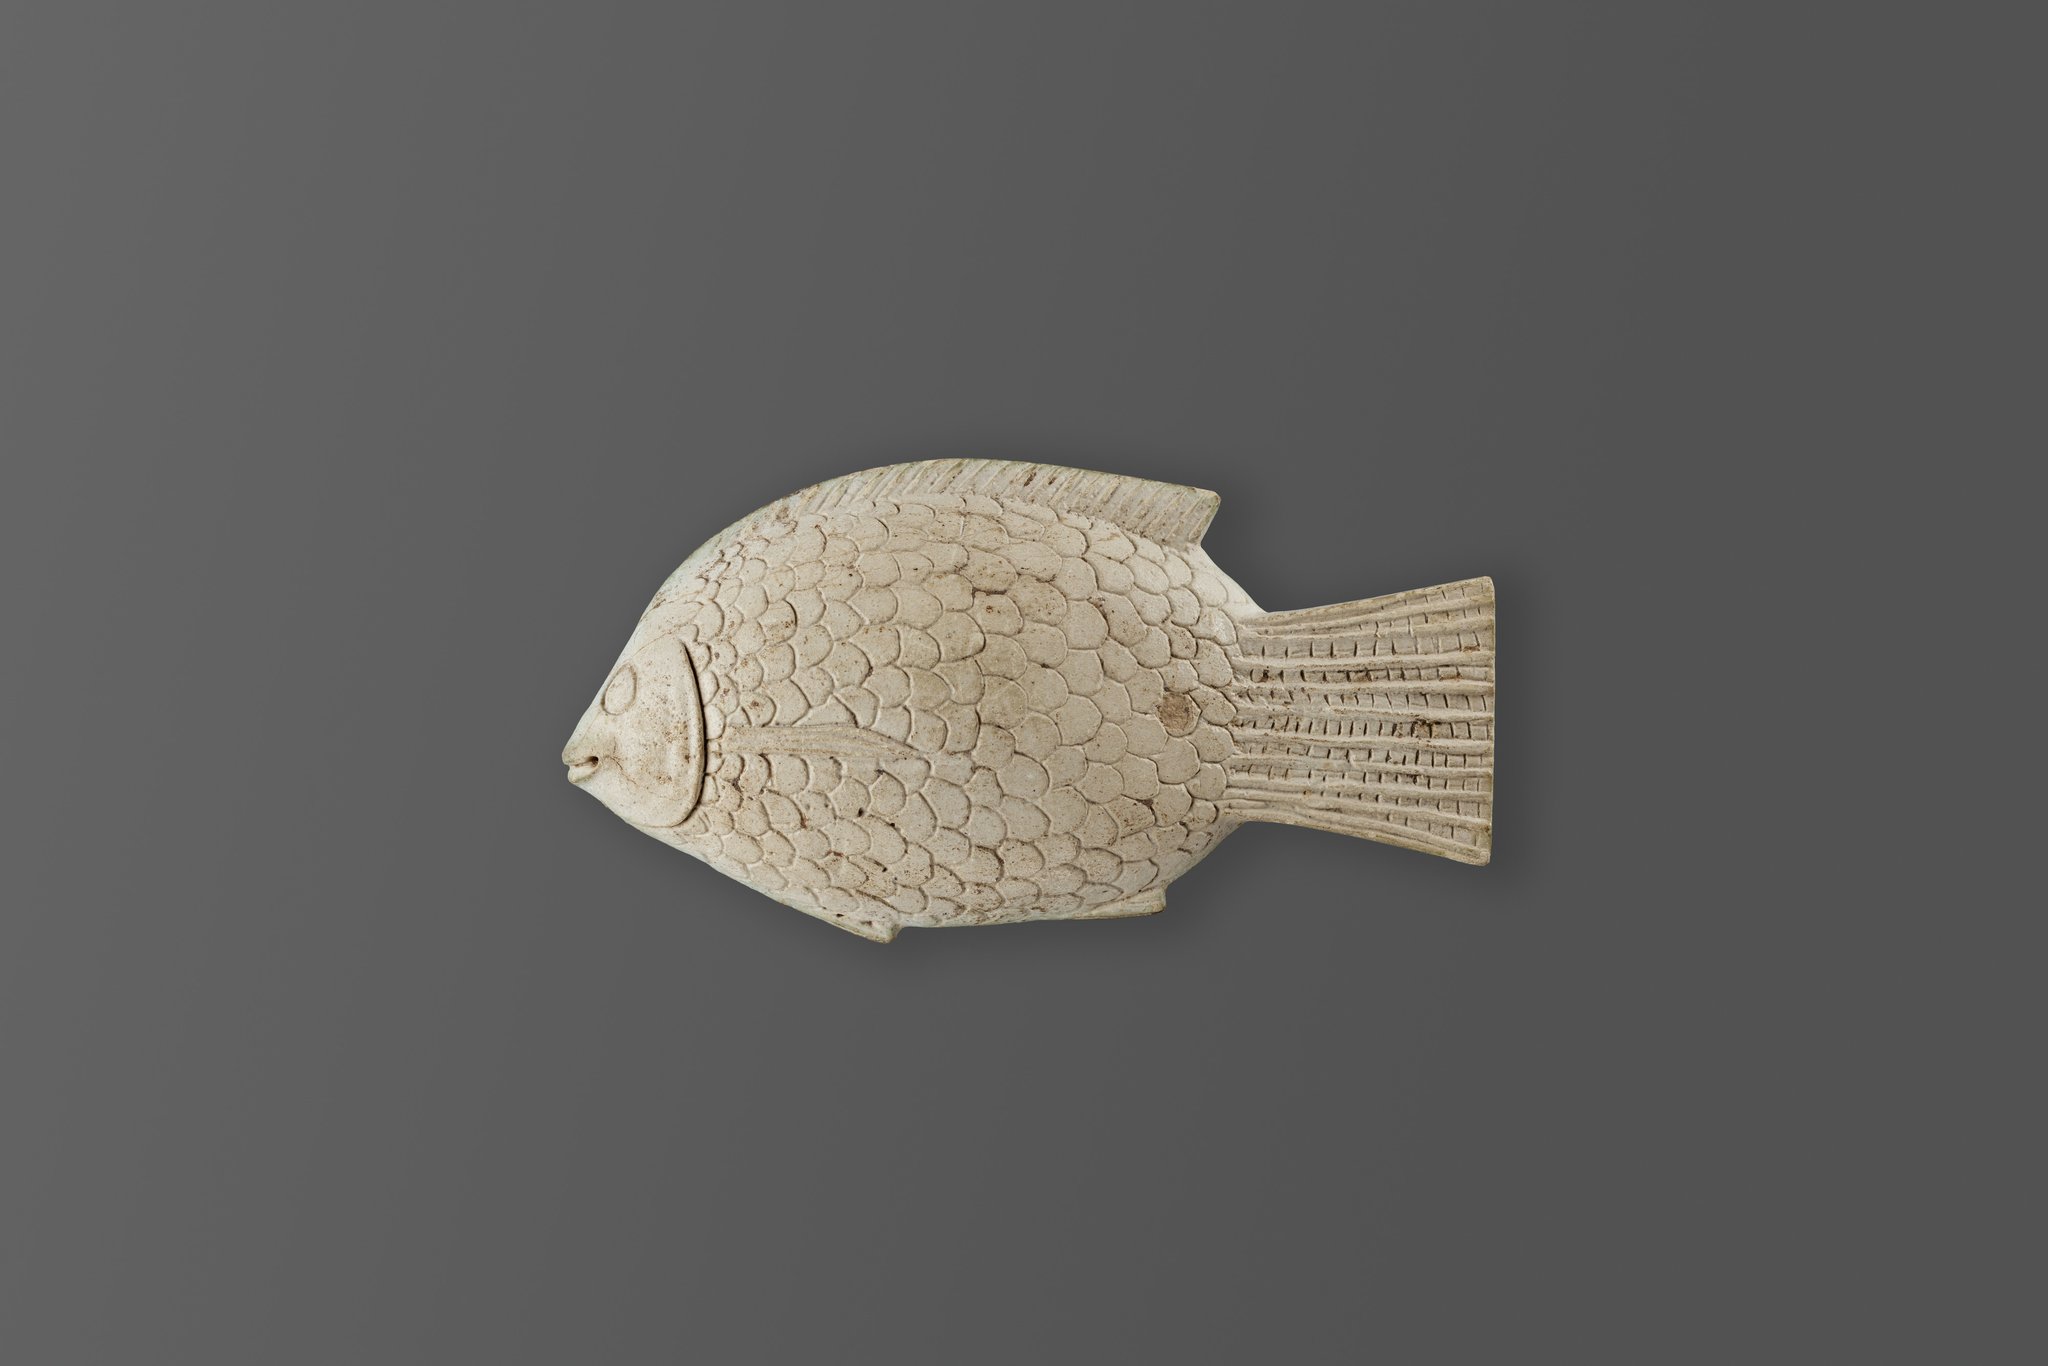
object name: dish, fish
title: Fish dish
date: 1400-1295 BCE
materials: faience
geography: egypt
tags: fish